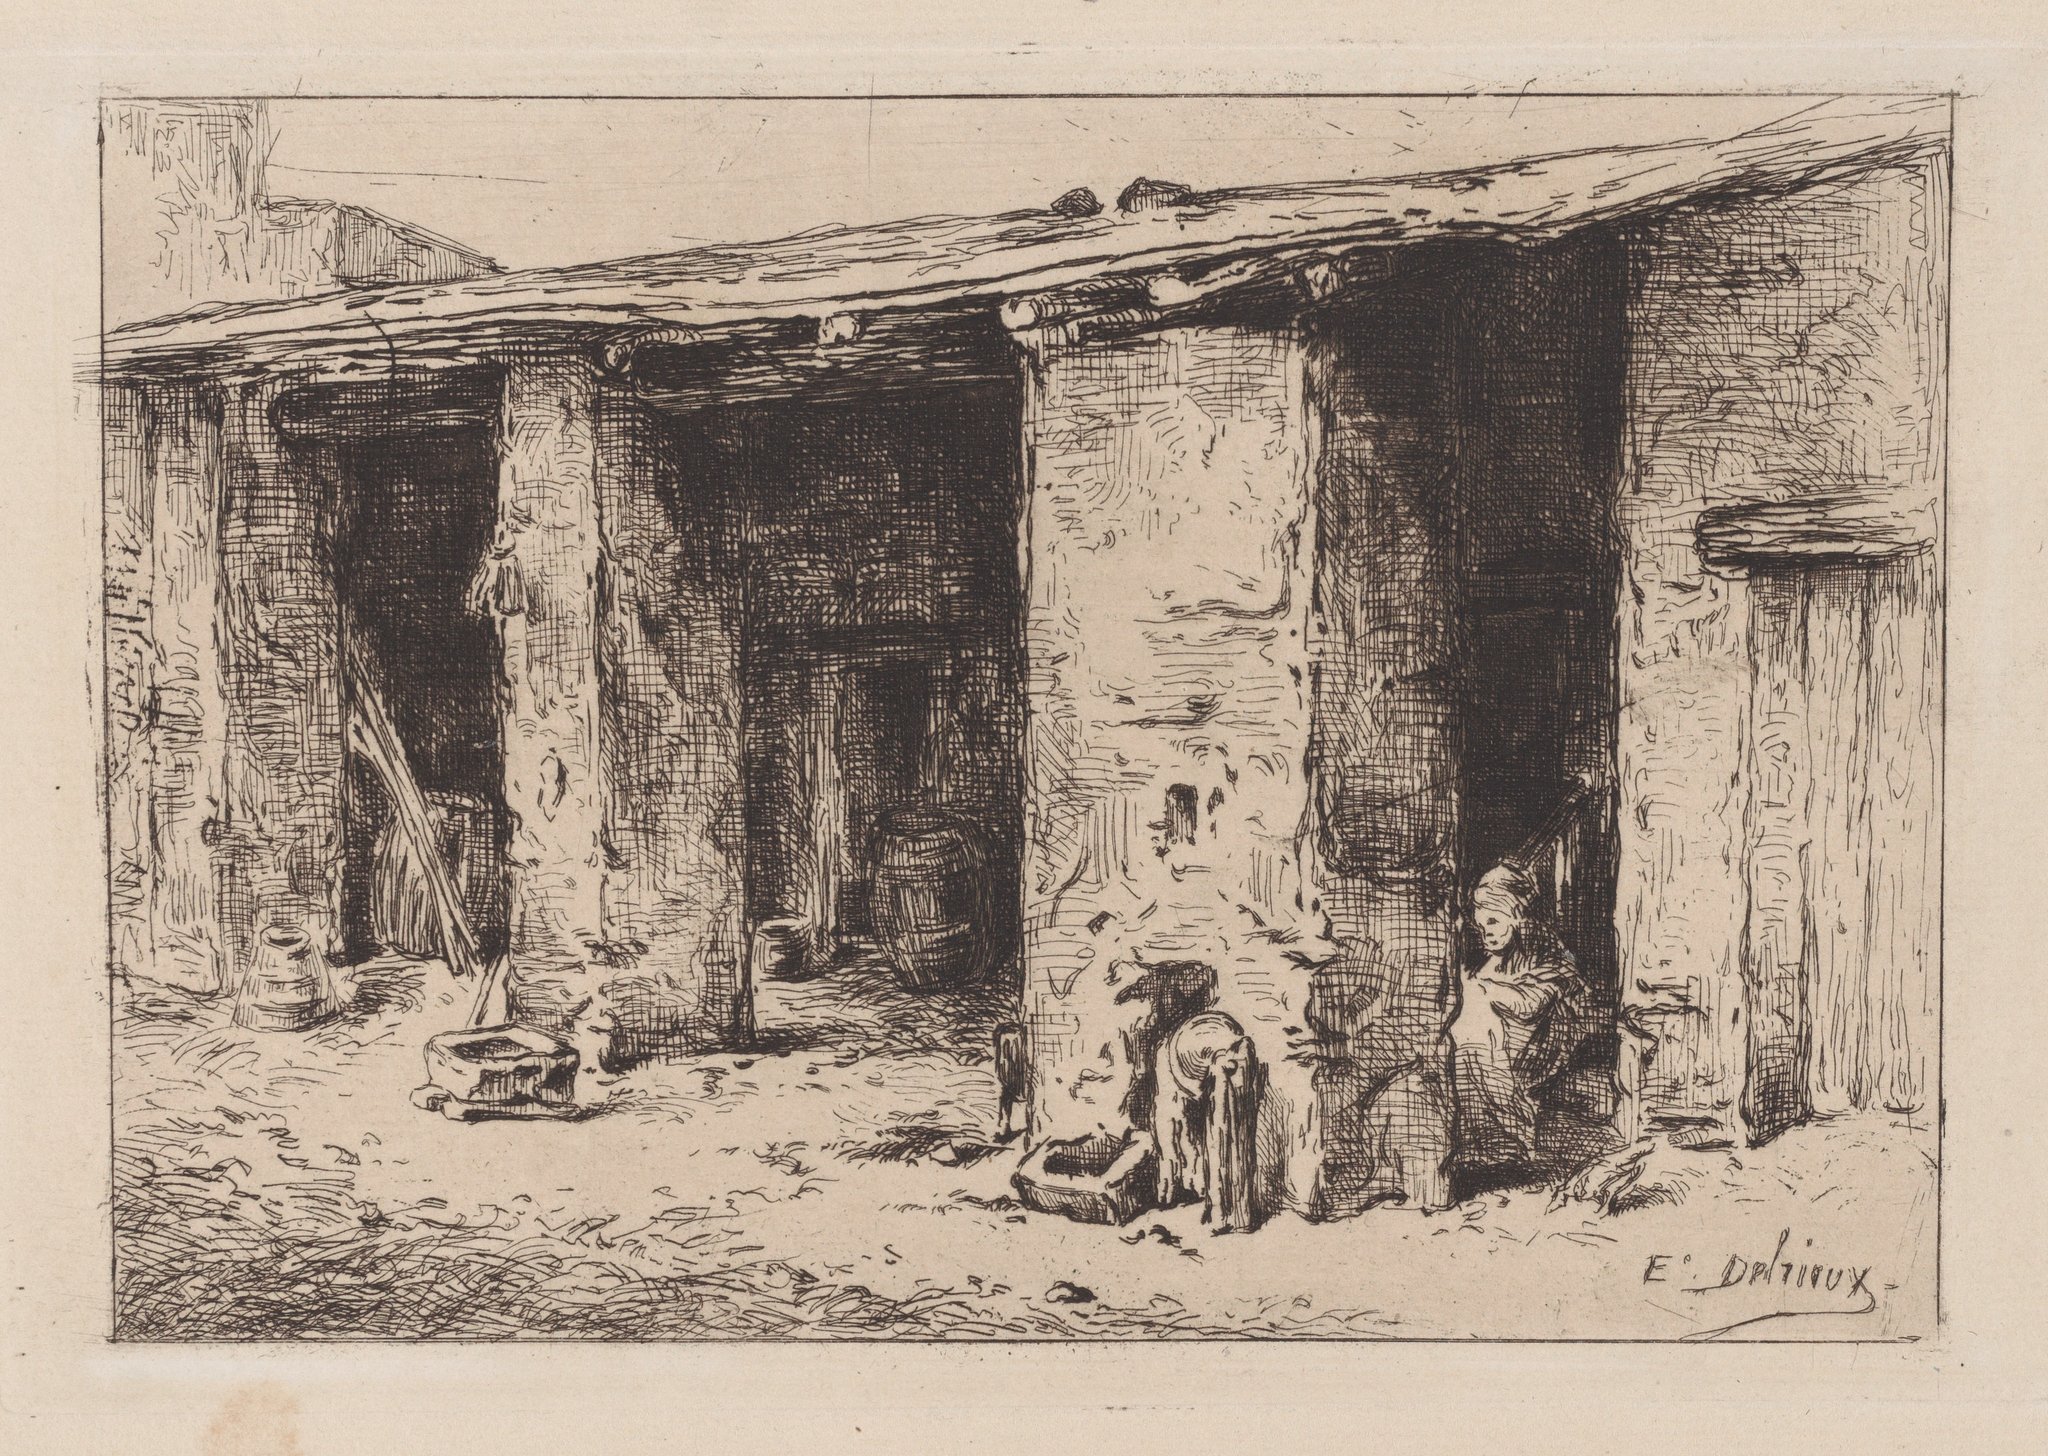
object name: print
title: Woman working within a shed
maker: etienne delrieux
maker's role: artist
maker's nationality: french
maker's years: 1850-1950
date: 1869-1880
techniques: etching